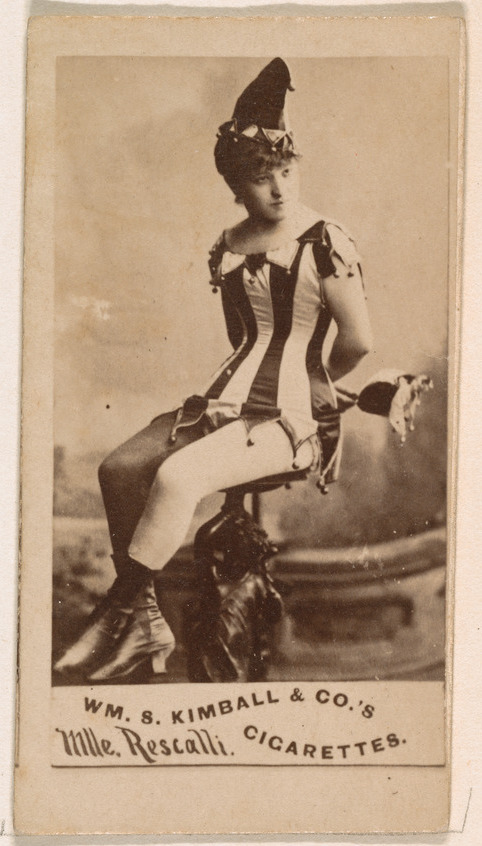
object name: photograph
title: Mlle. Rescalli, from the Actresses series (N203) issued by Wm. S. Kimball & Co.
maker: william s. kimball & company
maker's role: publisher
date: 1889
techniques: color lithograph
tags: portraits,women,actresses